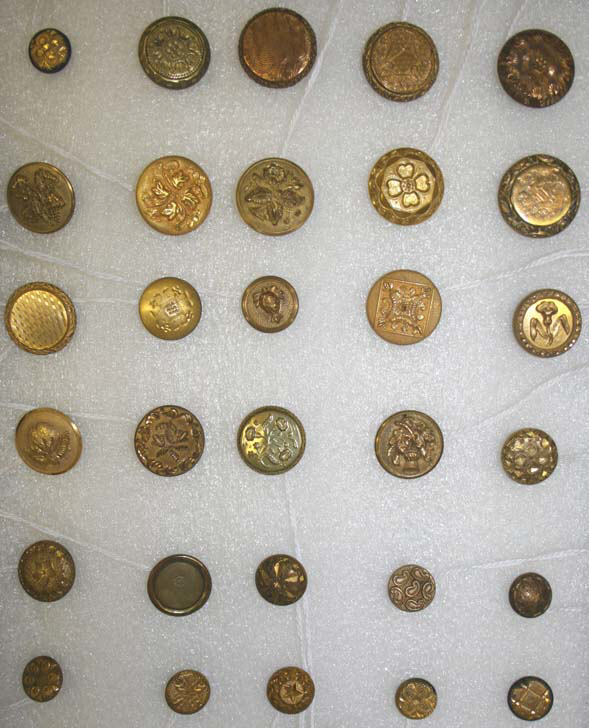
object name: button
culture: american or european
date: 1830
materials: metal